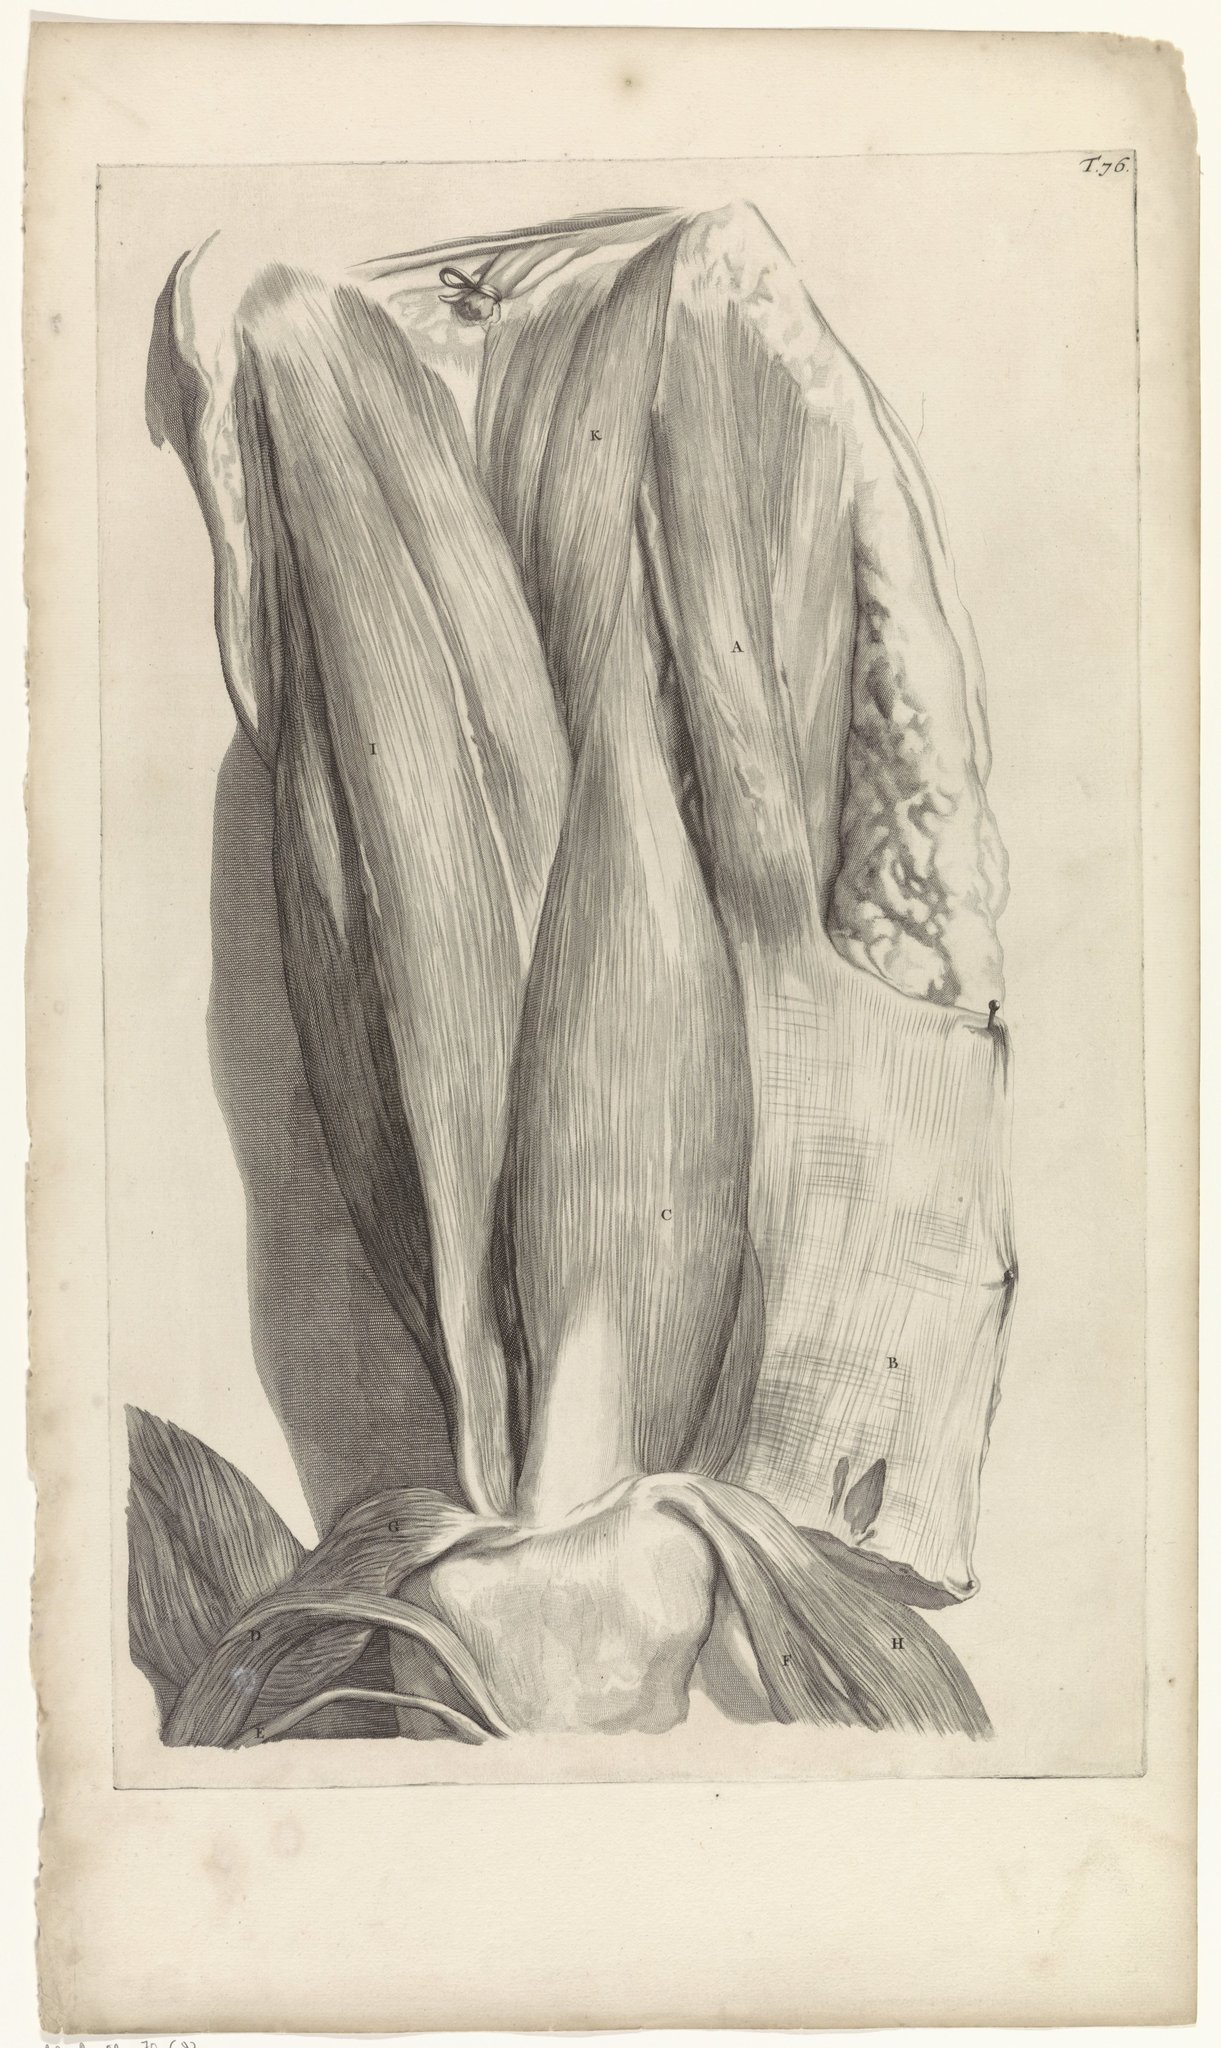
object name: print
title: Tweede anatomische studie van de spieren van het linkerdijbeen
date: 1685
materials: paper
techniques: engraving, etching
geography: amsterdam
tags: upper leg, muscles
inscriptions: collector's mark: Lugt 2228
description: Boekillustratie voor Bidloo, Godefridus. Anatomia humani corporis centum & quinque tabulis, per art. G. de Lairesse ad vivum delineatis, de monstrata, veterum recentiorumque inventis explicata plurimisque, hactenus non detectis, illustrata. Amsterdam: Weduwe Joannes van Someren, Hendrick Boom en erven Dirk Boom, 1685.